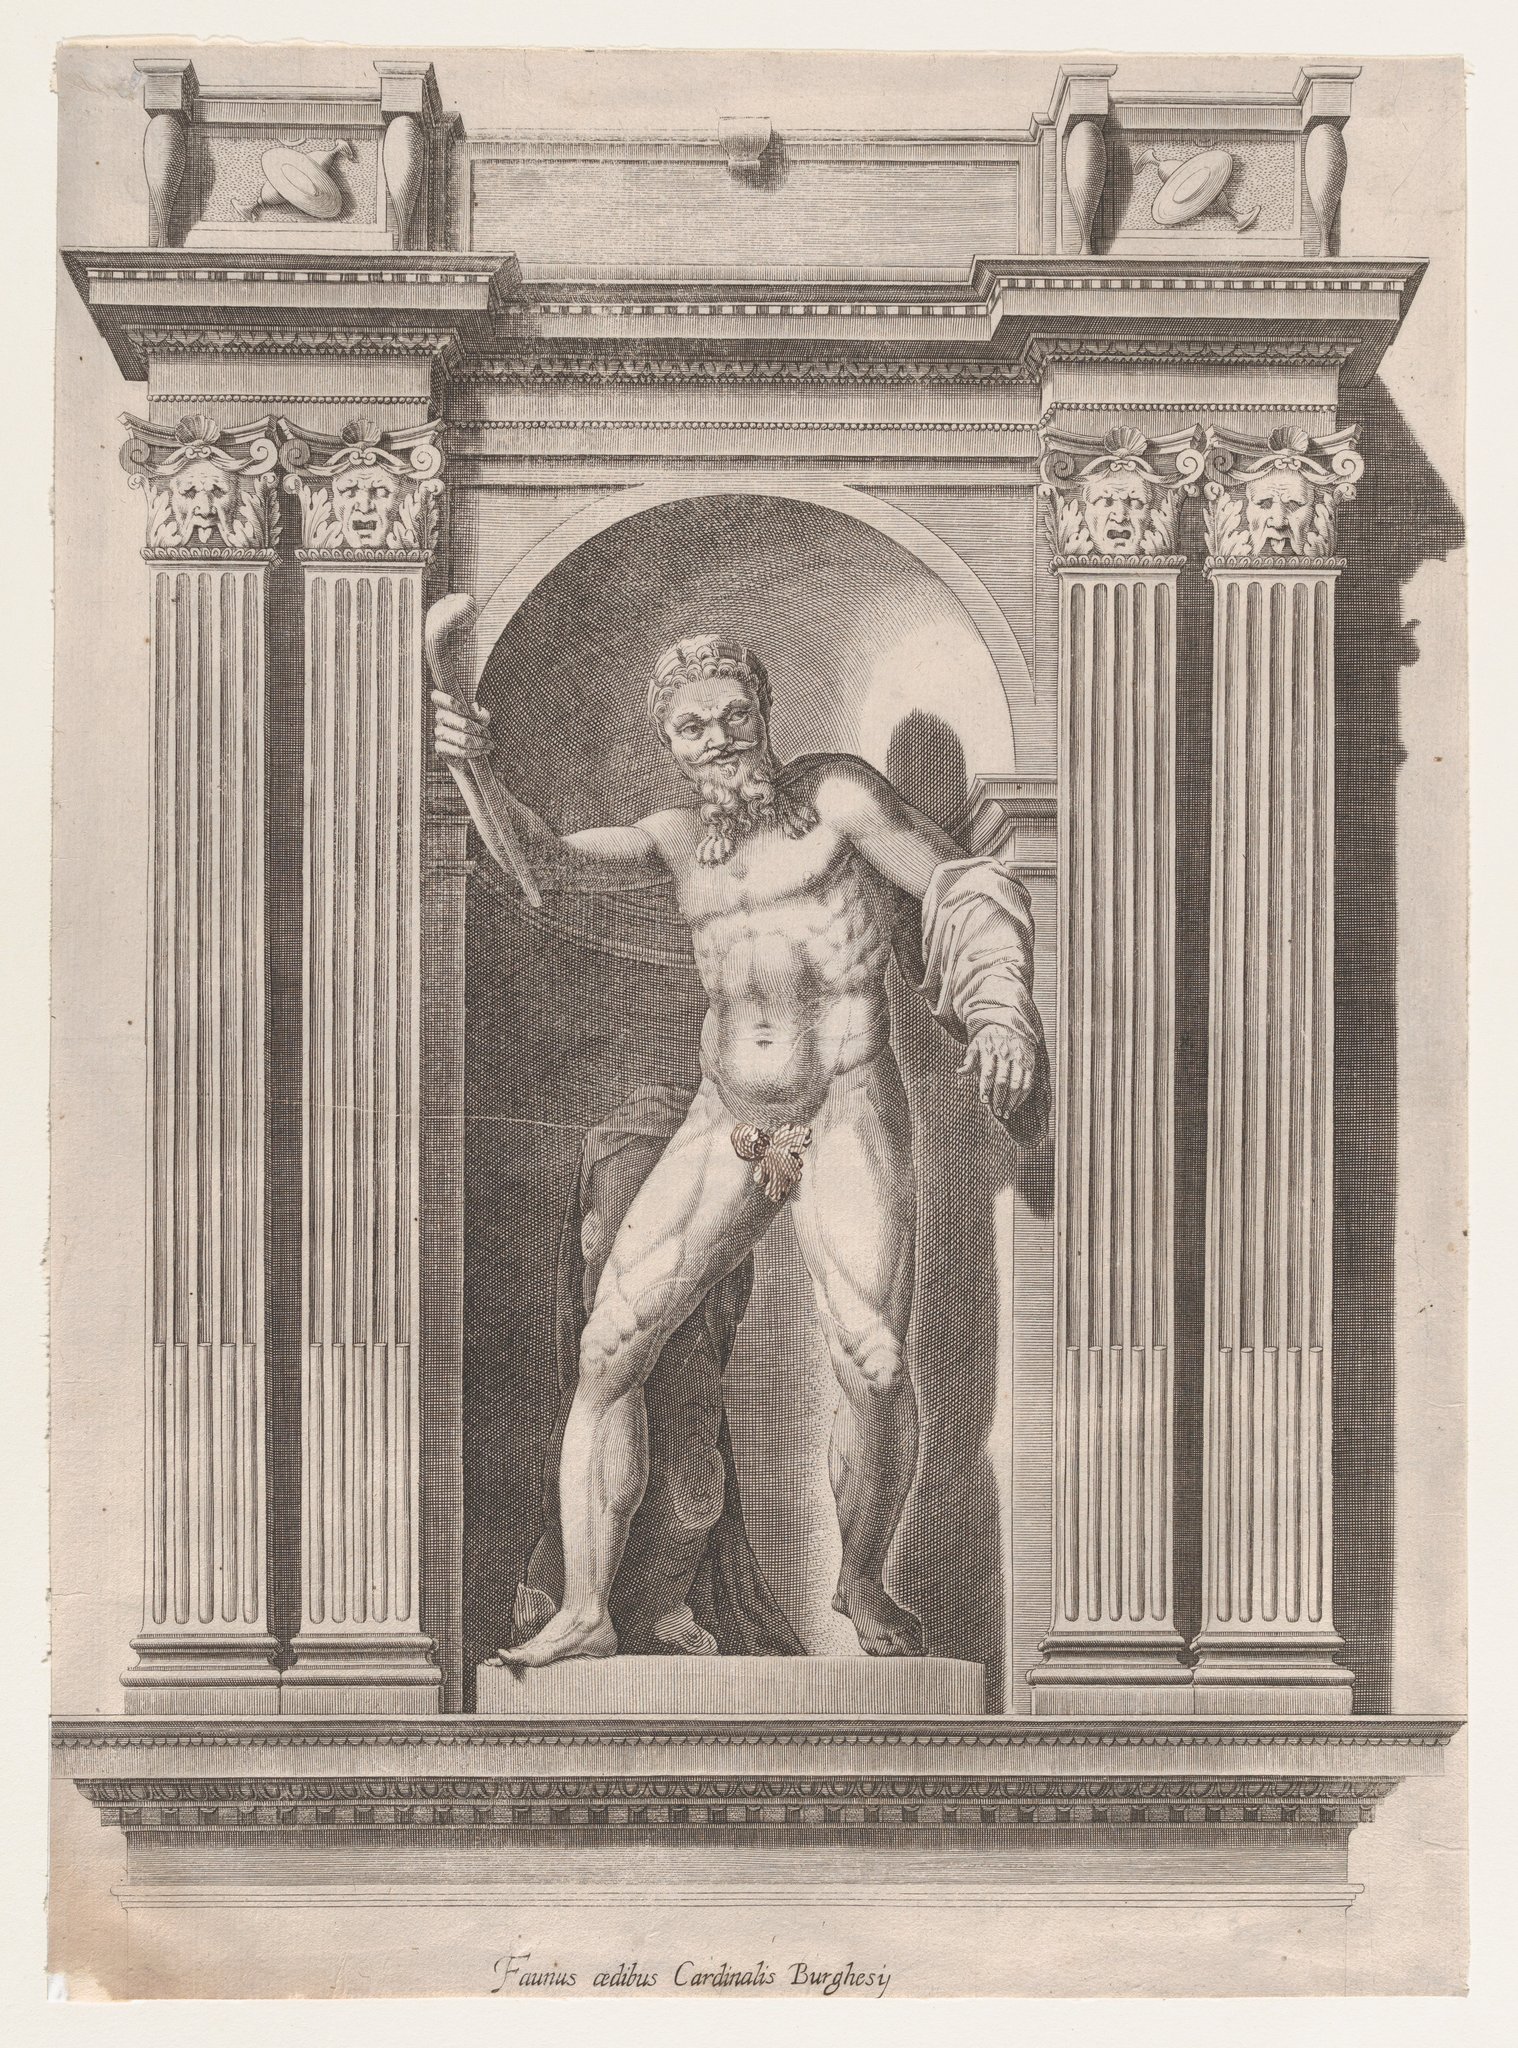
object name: print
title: Sculpture of a faun standing in a niche after a statue in Scipione Borghese's villa, from "Speculum Romanae Magnificentiae"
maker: Anonymous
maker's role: artist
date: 1501-1600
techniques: etching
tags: sculpture,men